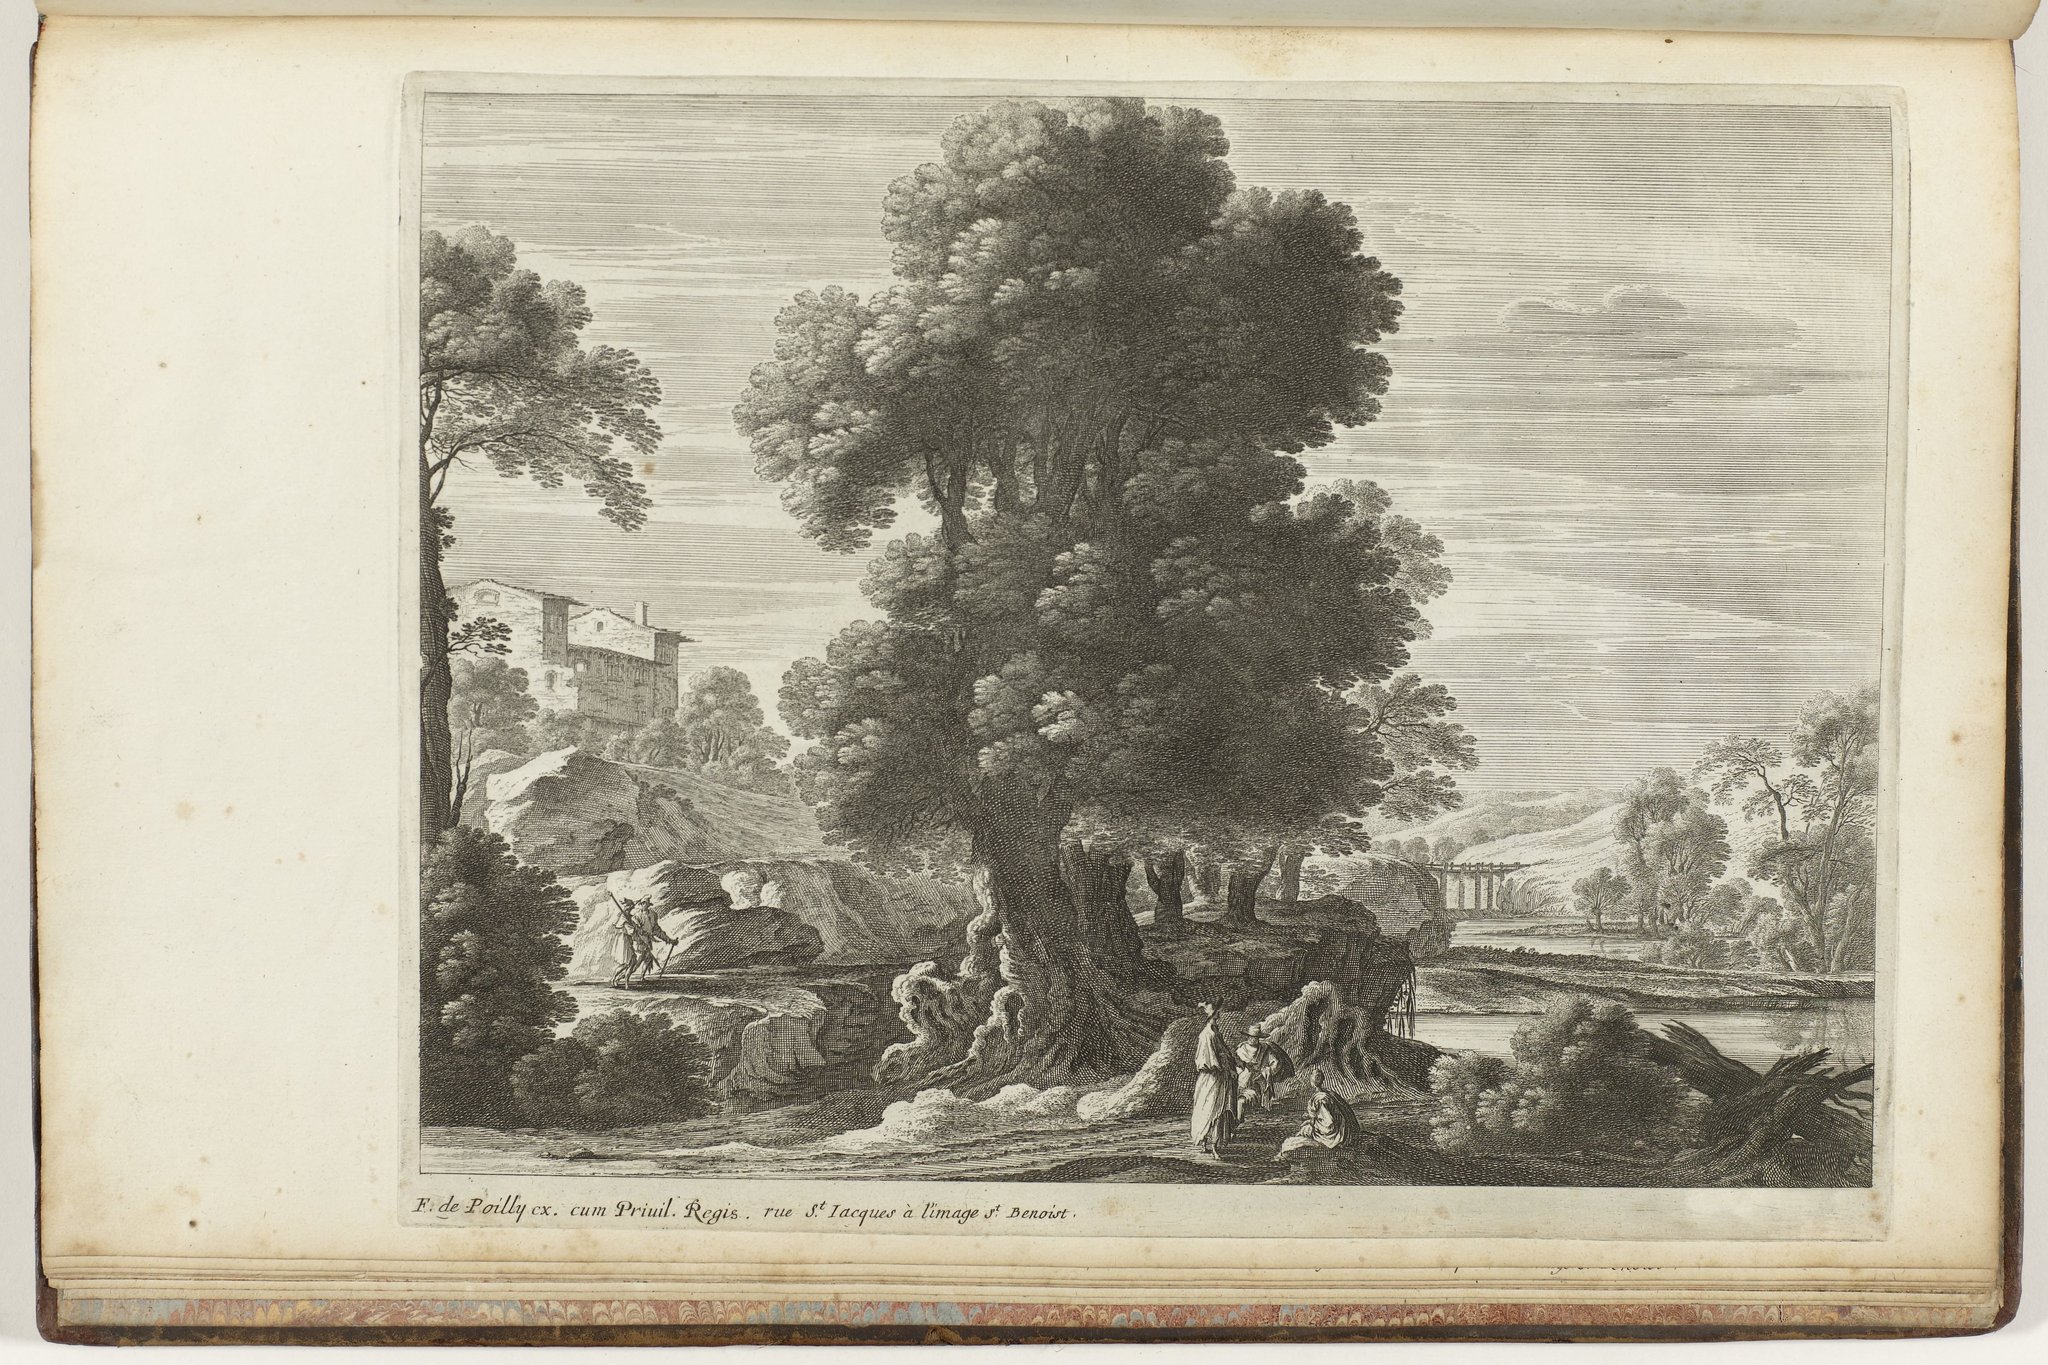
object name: print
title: Landschap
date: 1680-1695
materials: paper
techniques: etching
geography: paris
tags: landscapes in the temperate zone (+ landscape with figures, staffage)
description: Landschap. Ontwerp voor schildering boven schoorsteenmantel of deur? Prent maakt deel uit van een album.